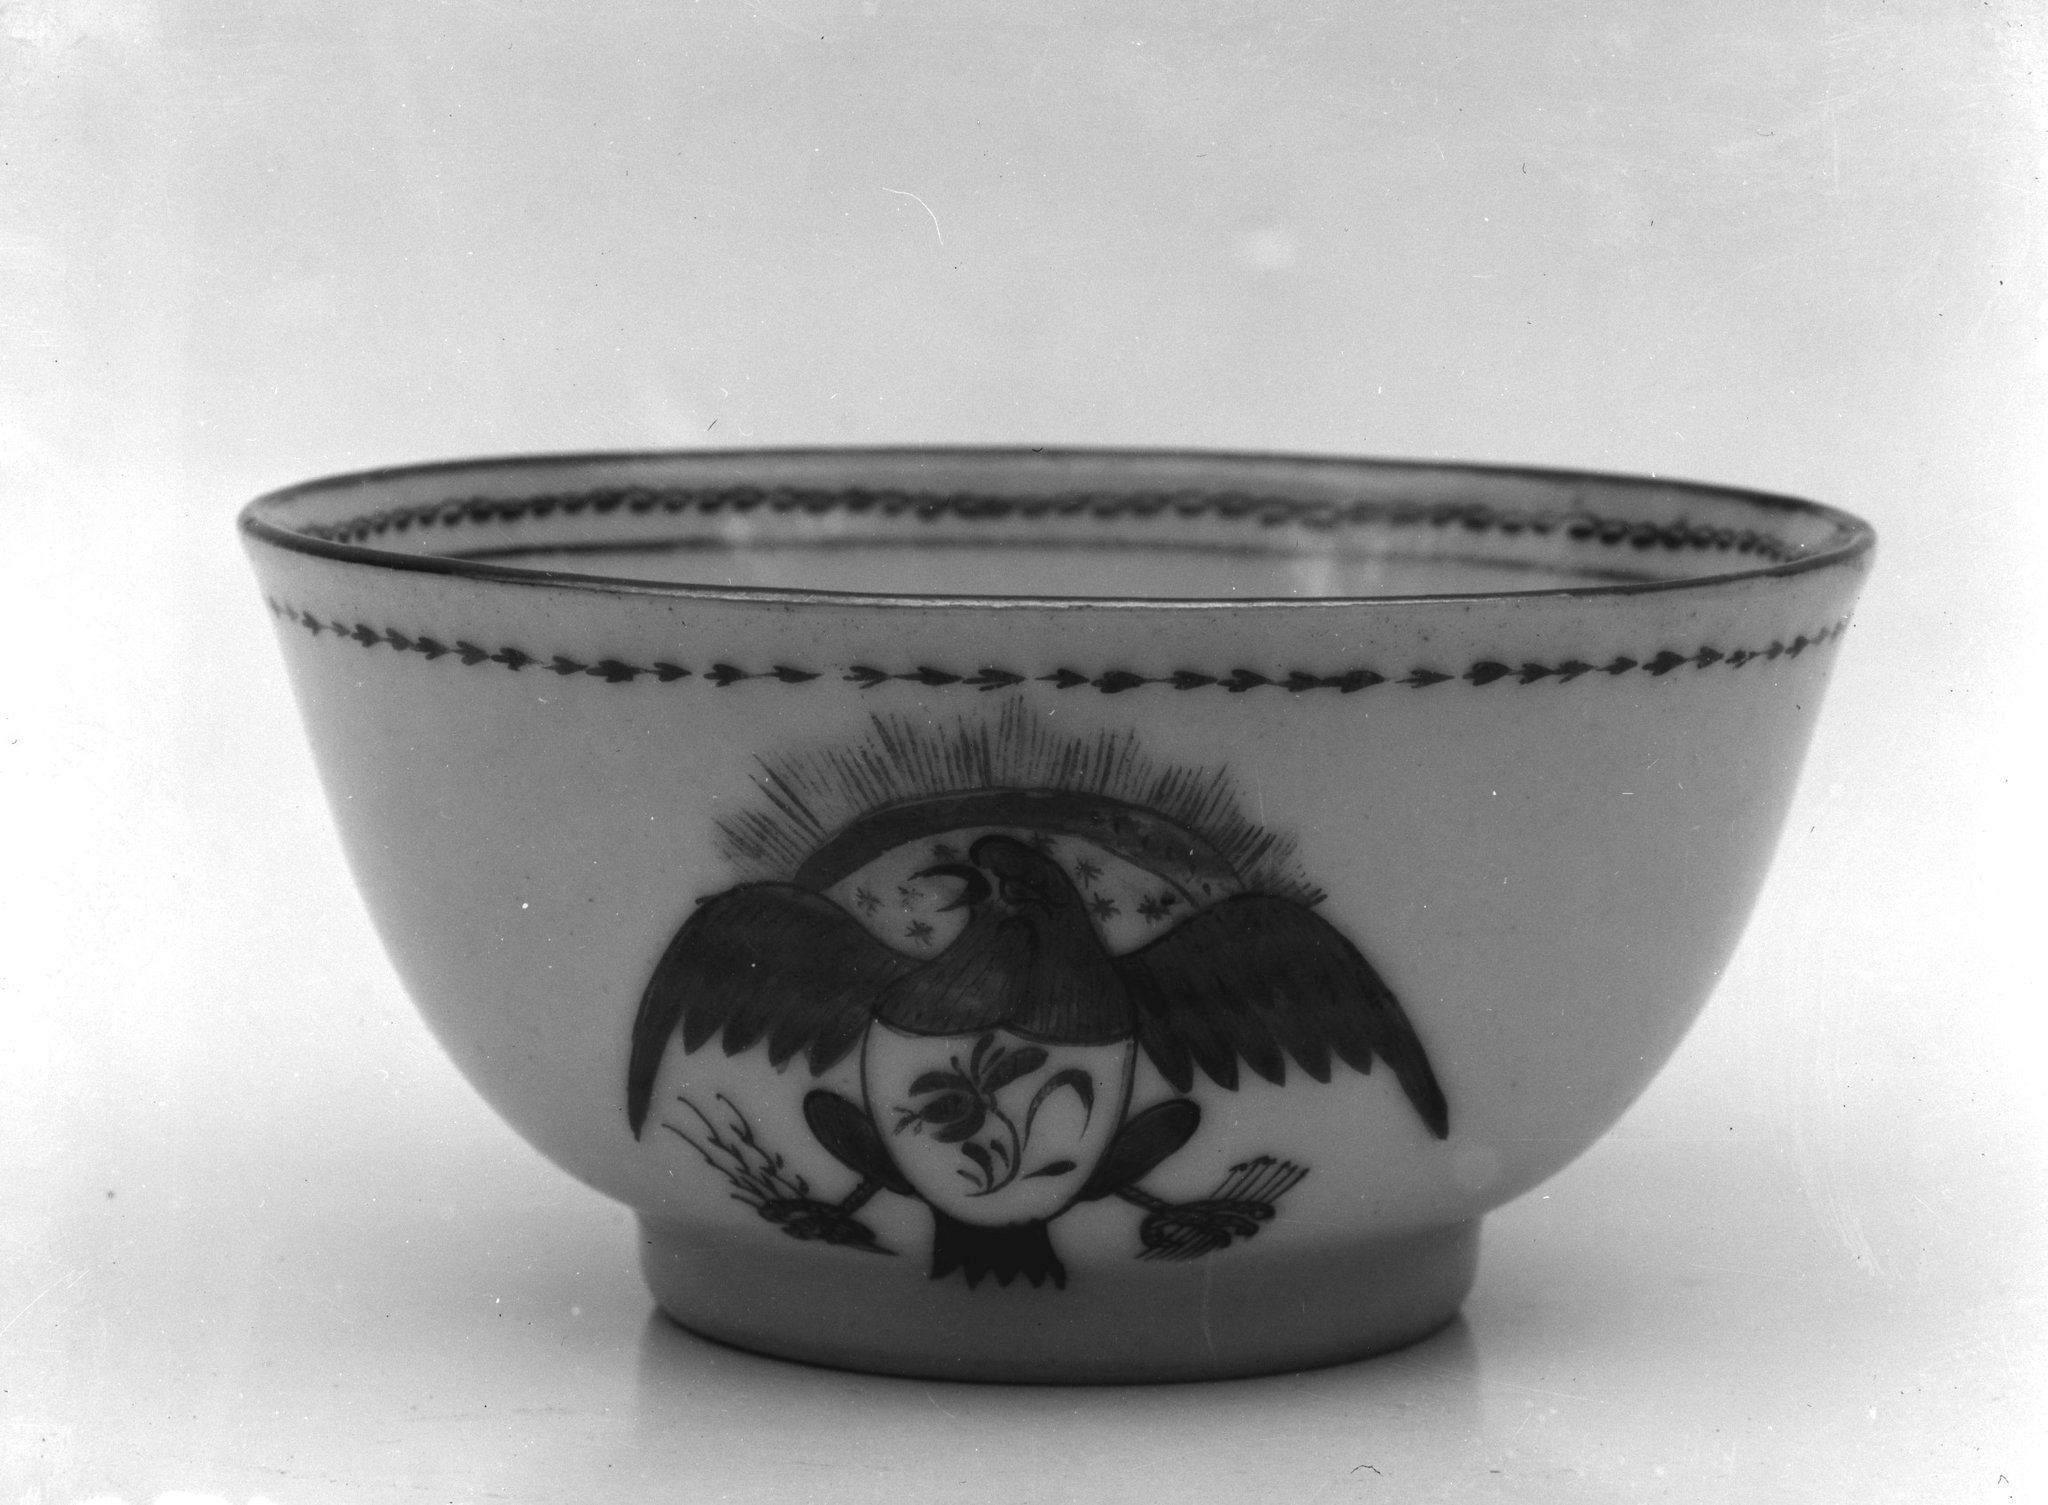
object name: cup and saucer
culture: chinese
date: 1800-1815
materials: porcelain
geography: china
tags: eagles